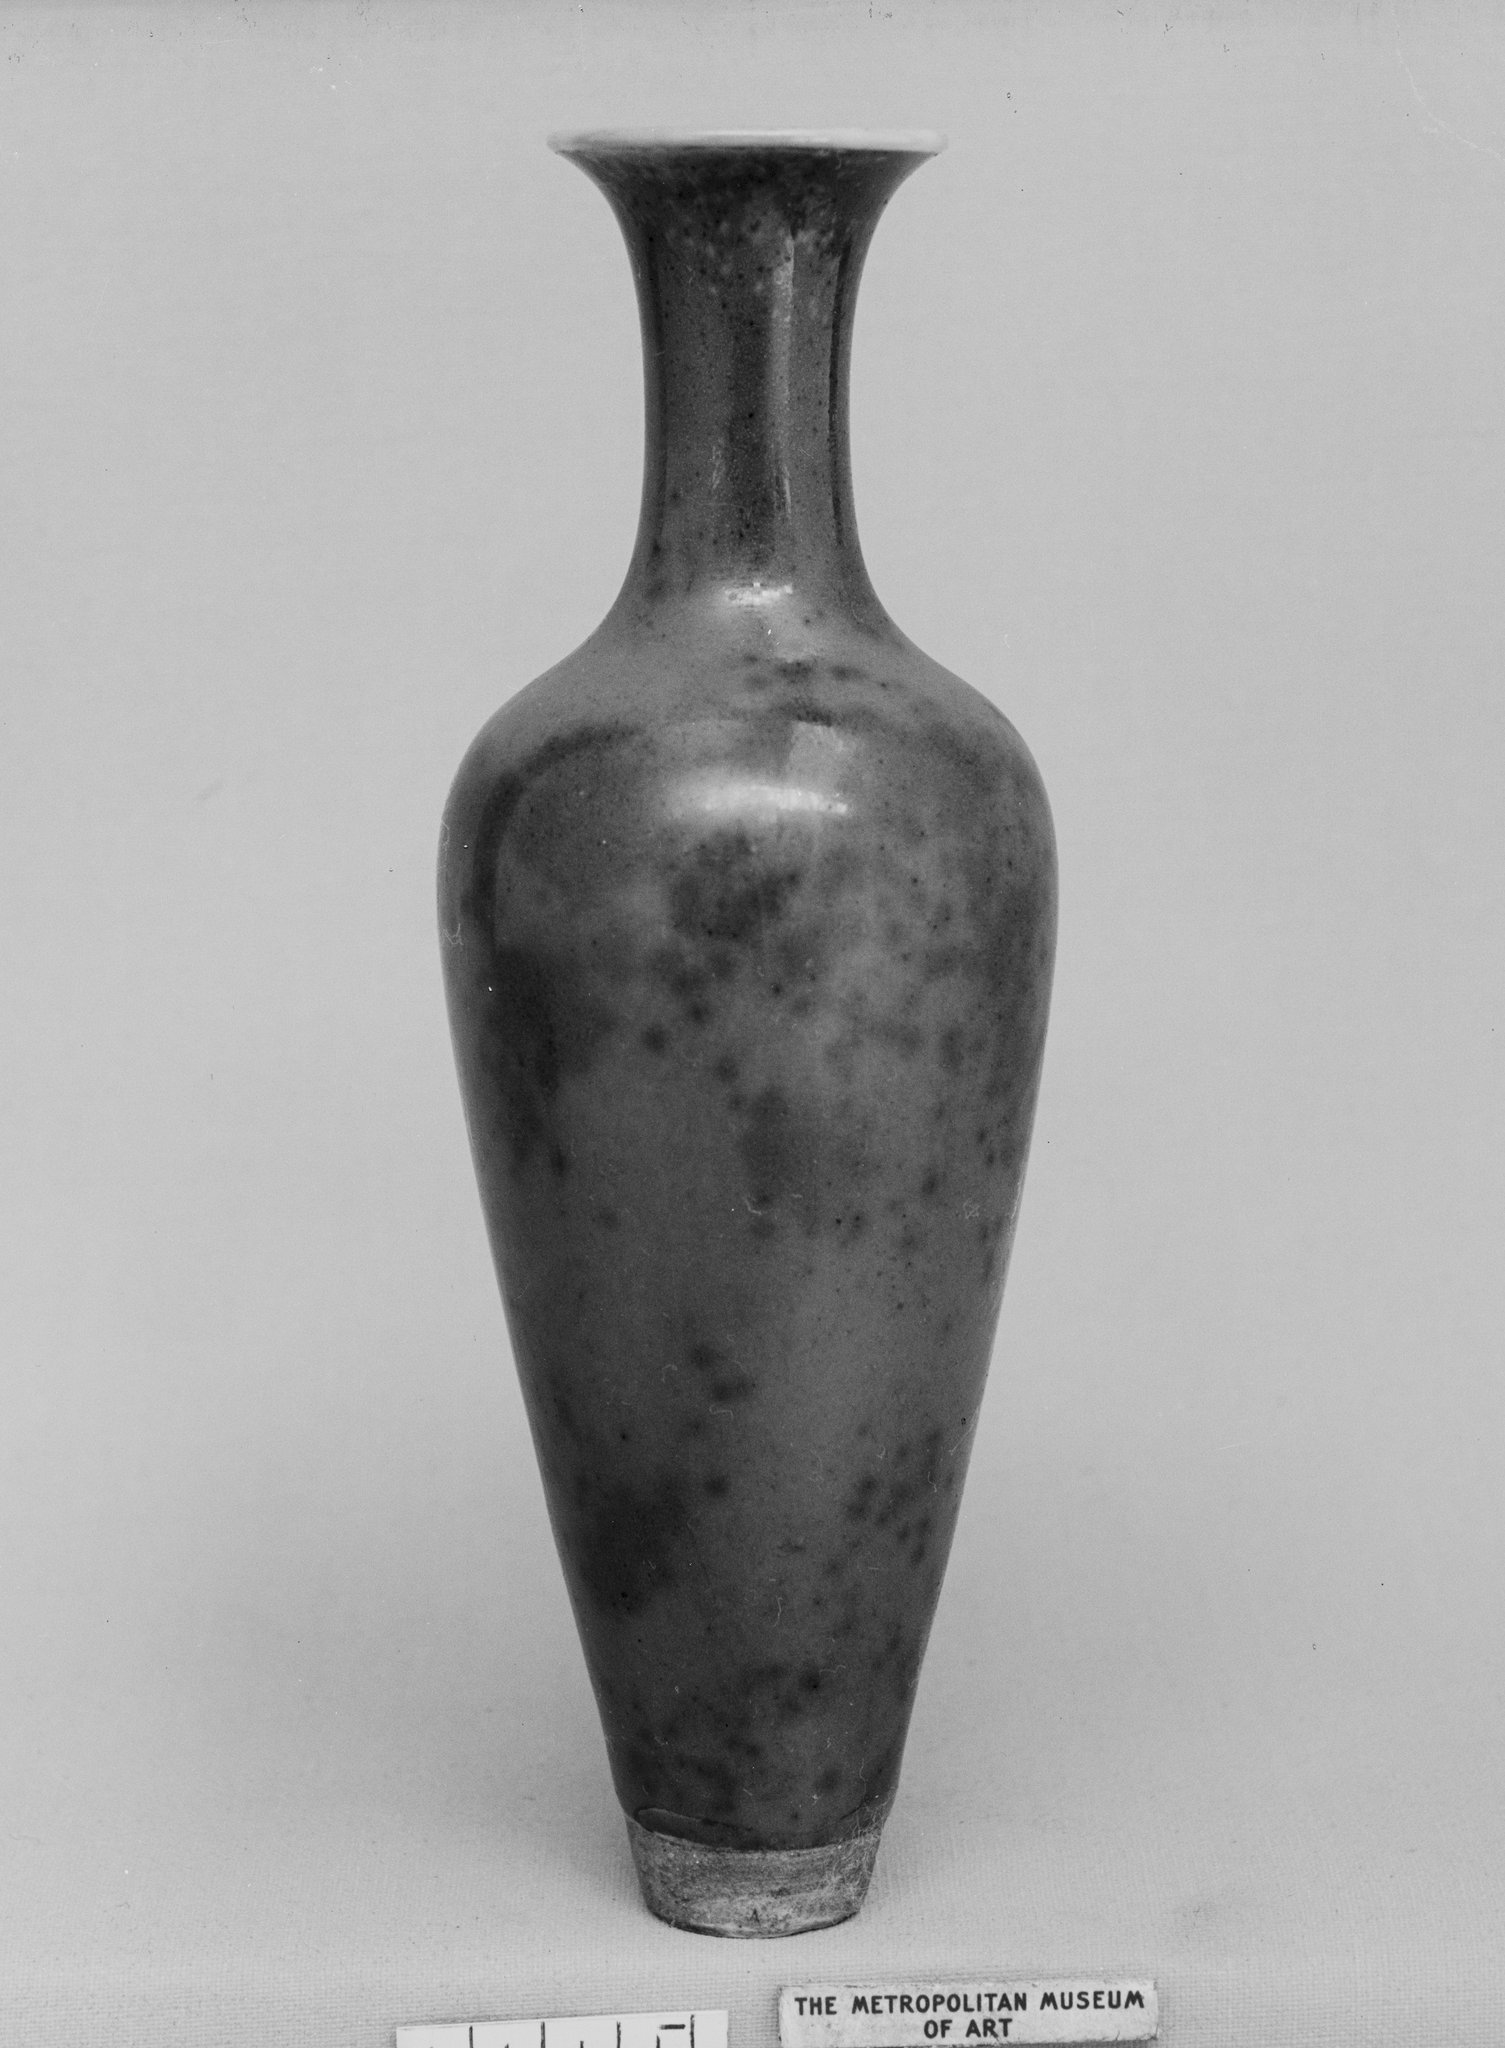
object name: vase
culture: chinese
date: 1662-1722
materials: porcelain